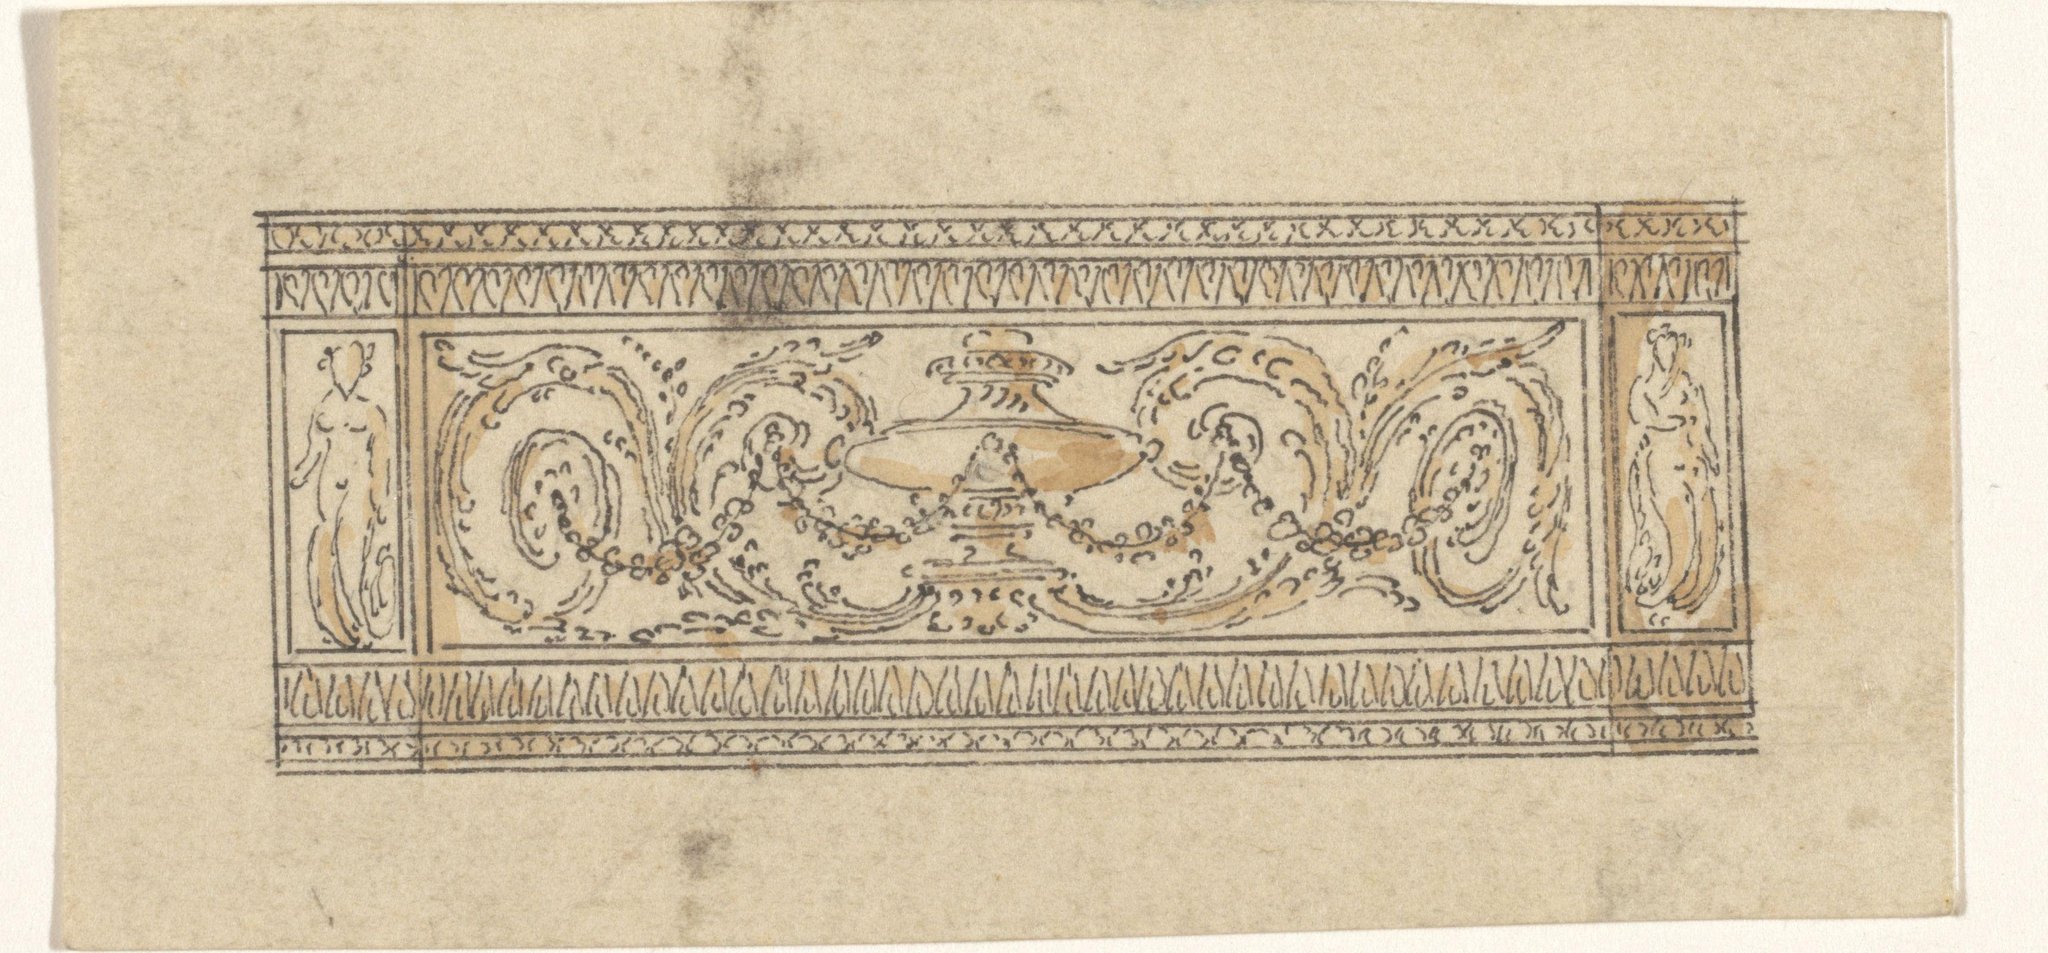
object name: design drawing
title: Rechthoekige snuifdoos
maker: Anonymous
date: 1780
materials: ink, paper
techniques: brush, pen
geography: paris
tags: snuff-box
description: Vooraanzicht van een rechthoekige snuifdoos met afgeschuinde hoeken, de voorzijde versierd met een vaas te midden van bladvoluten, de hoeken met in voluten uitlopende naakte vrouwenfiguren.